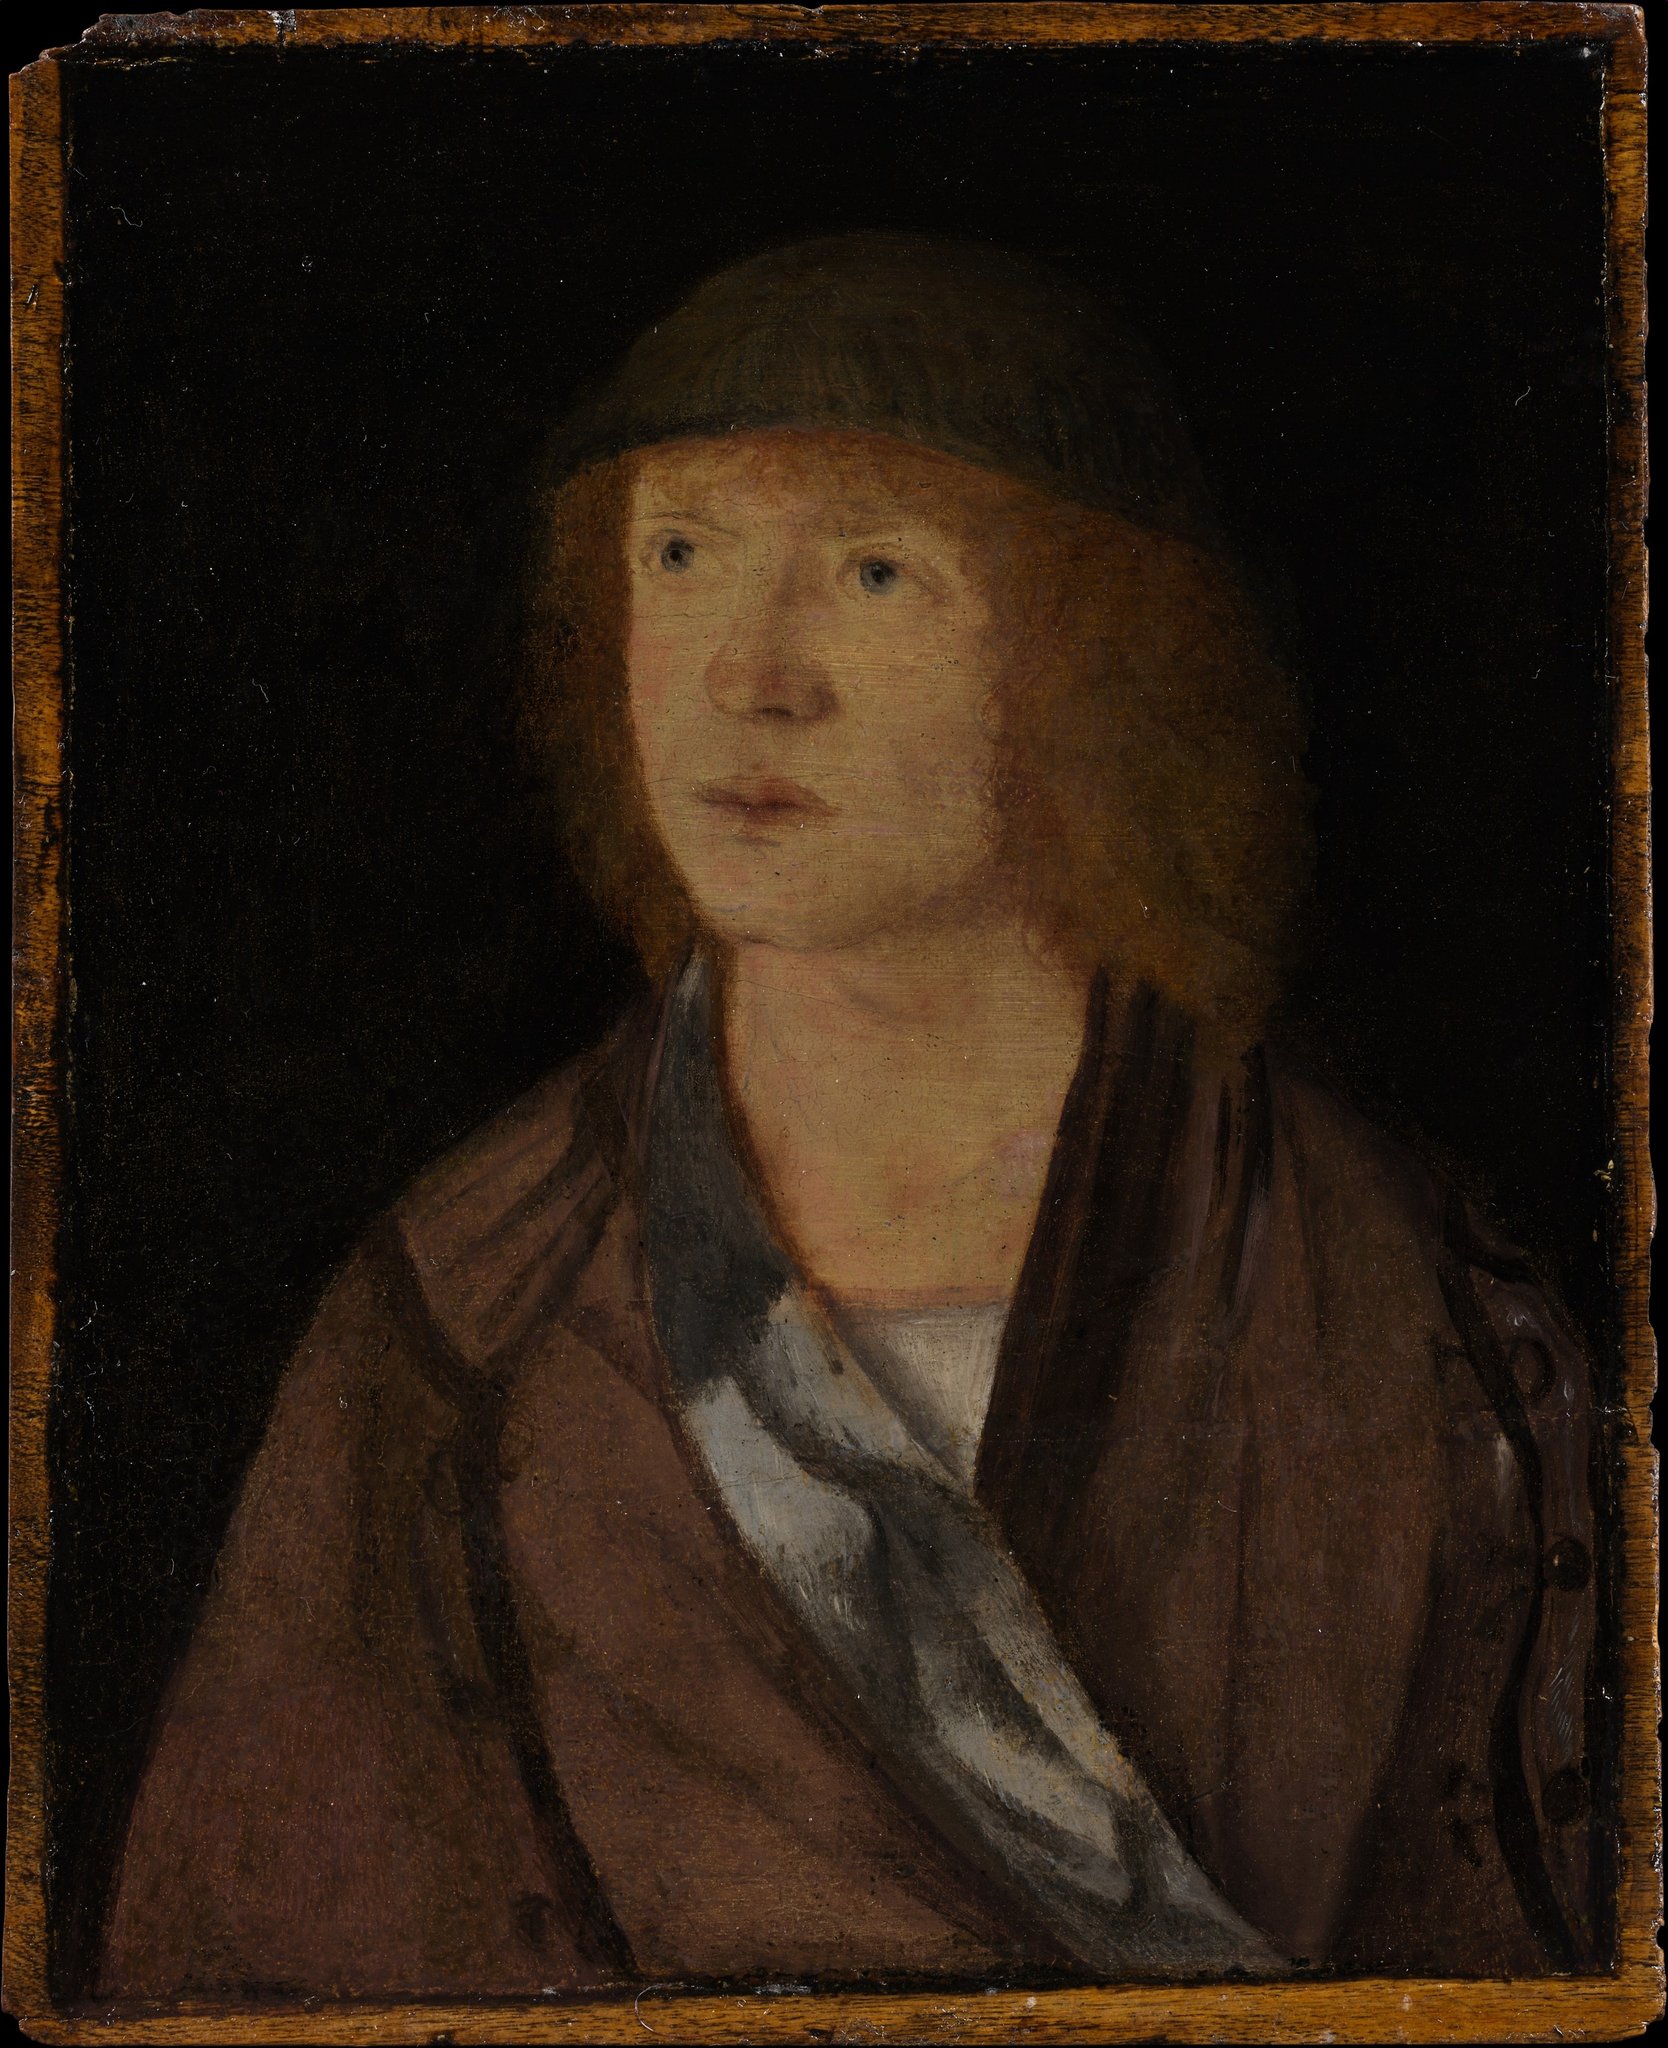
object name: painting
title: Portrait of a Young Man; (reverse) Girl Making a Garland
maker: hans süss von kulmbach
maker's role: artist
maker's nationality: german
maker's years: 1480-1522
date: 1508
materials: oil, wood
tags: girls,men,portraits,cats